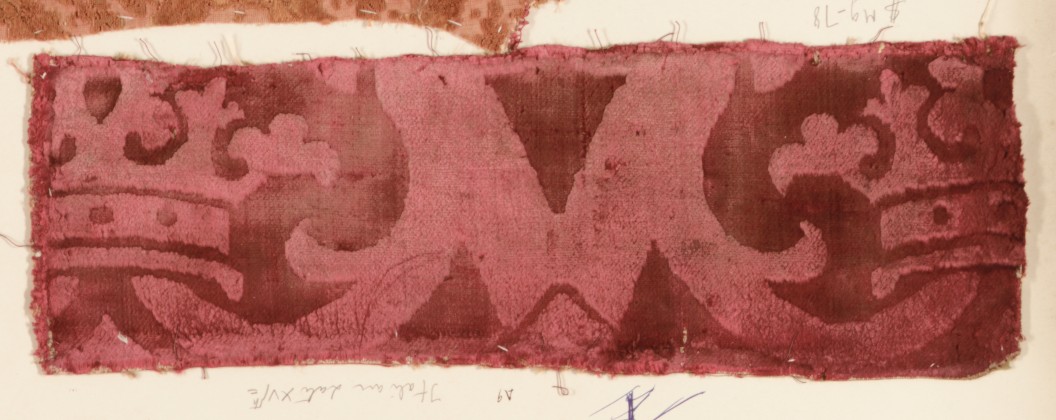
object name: fragment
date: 1567-1600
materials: silk